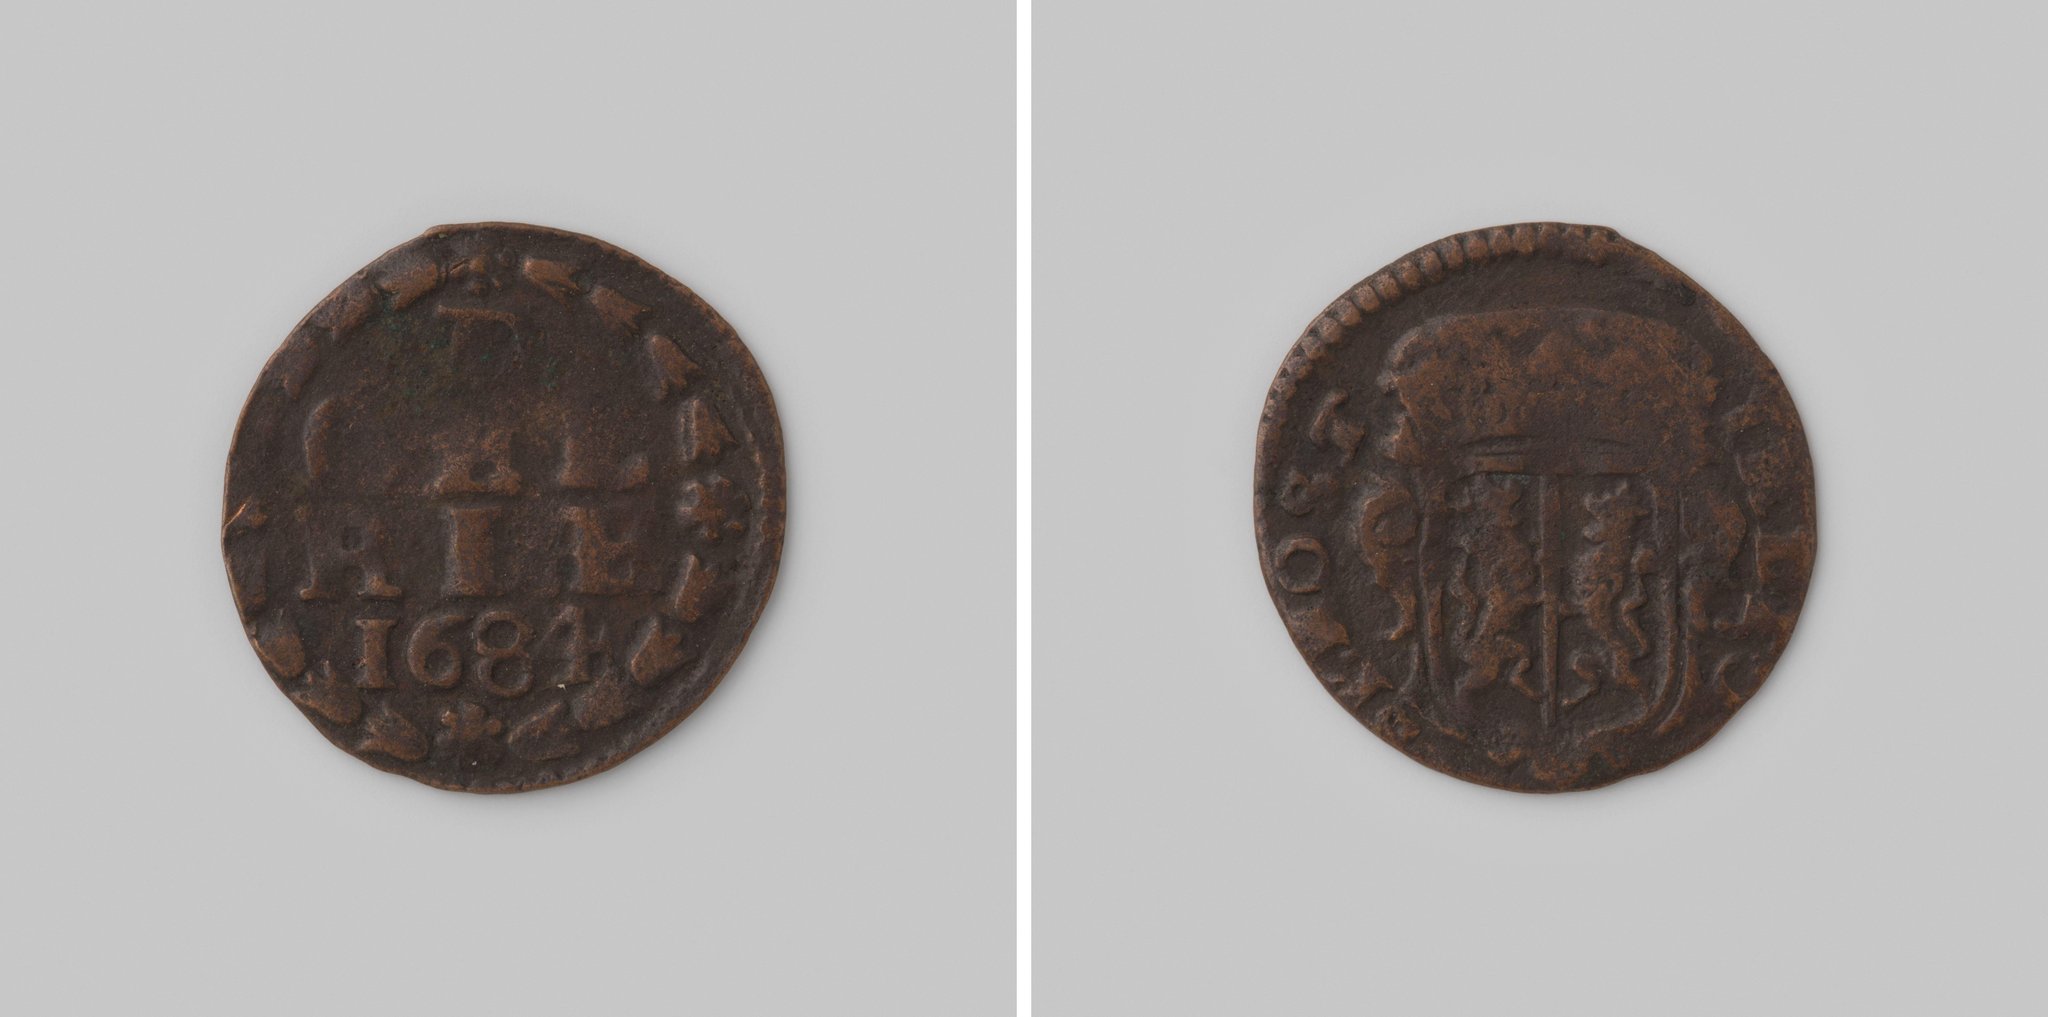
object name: coin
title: Gelderland, duit, 1684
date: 1684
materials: copper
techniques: striking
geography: harderwijk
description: Koperen munt. Voorzijde: binnen lauwerkrans in drie regels D/GEL/RIAE, daaronder jaartal. Keerzijde: gekroond Gelders wapenschild.